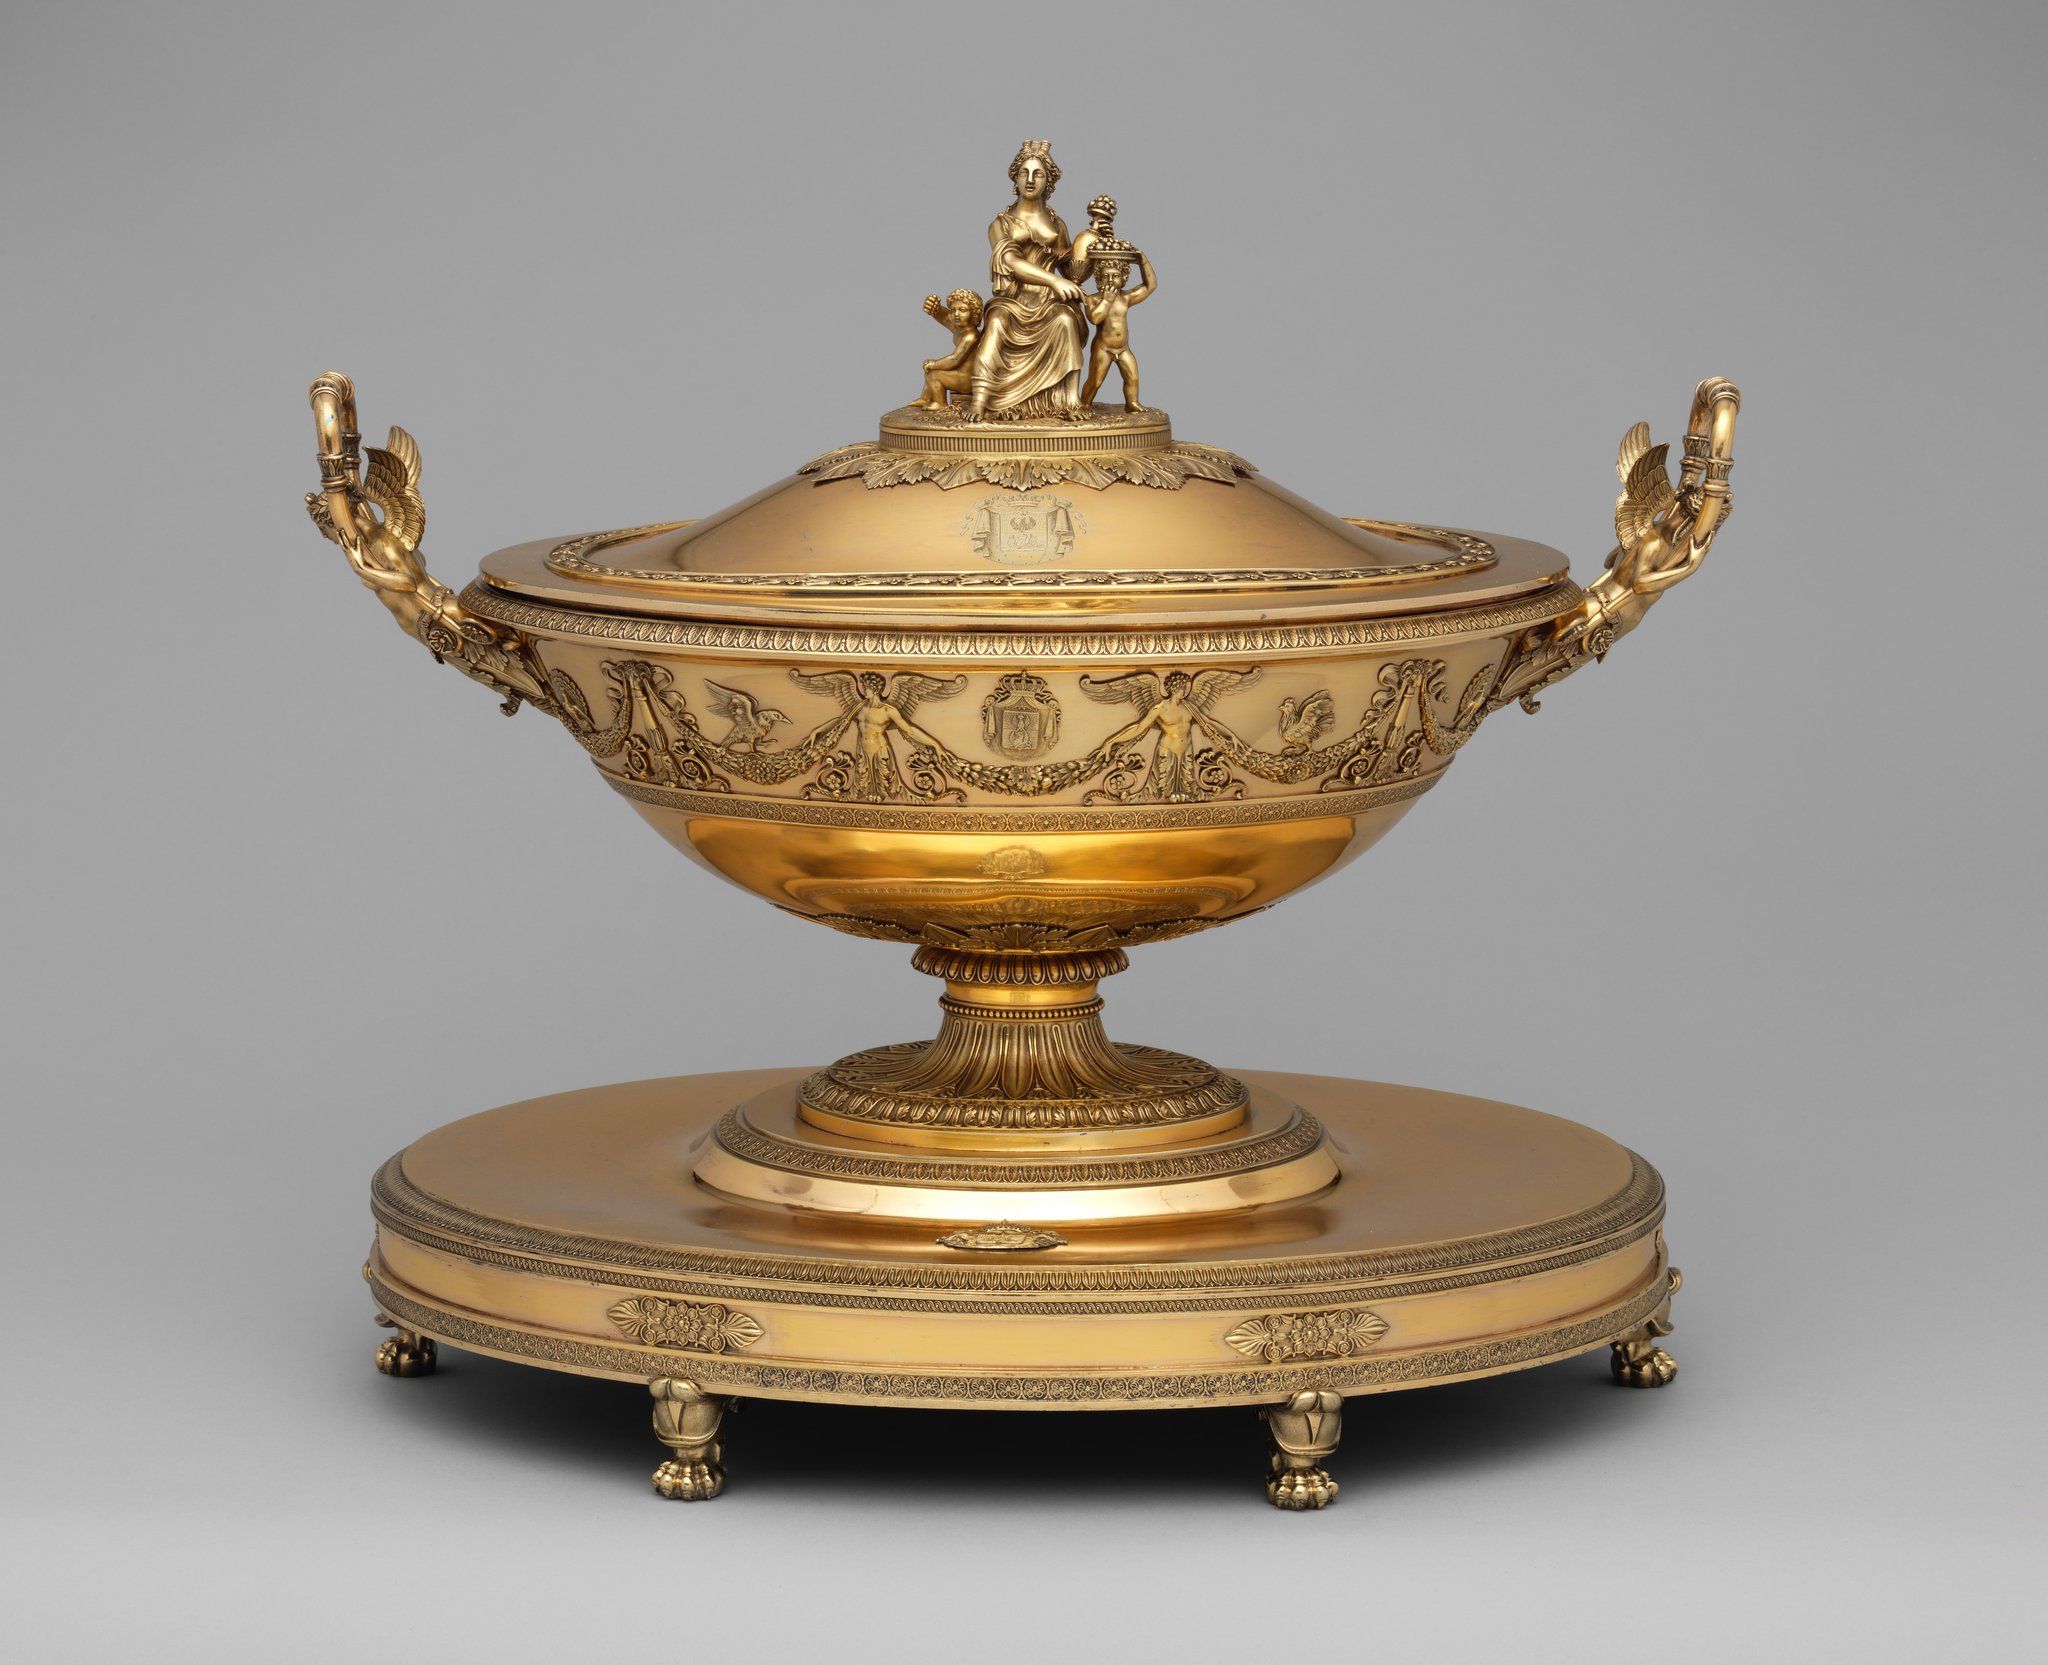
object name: tureen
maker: charles percier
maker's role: designer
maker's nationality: french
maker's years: 1764-1838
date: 1794-1814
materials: silver gilt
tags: birds,garlands,children,women,coat of arms